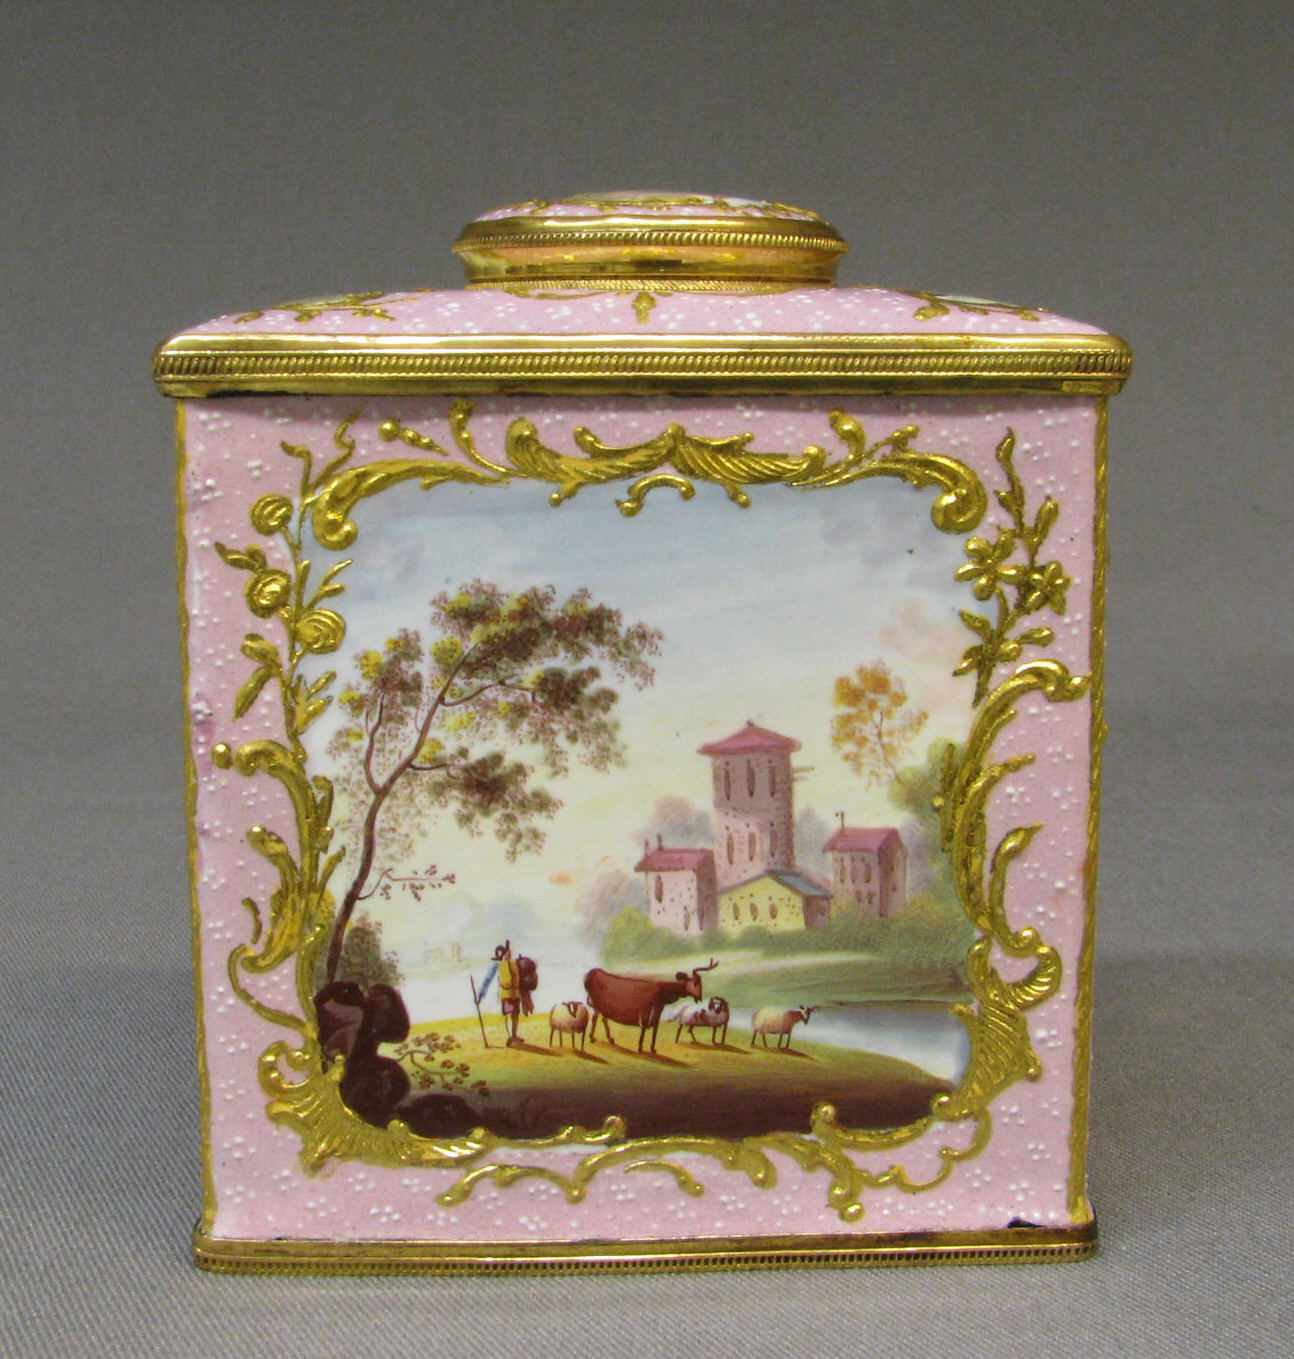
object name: tea caddy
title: Tea caddy (part of a set)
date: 1765-1770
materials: copper, enamel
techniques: painting, polychrome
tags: animals,landscapes,shepherds